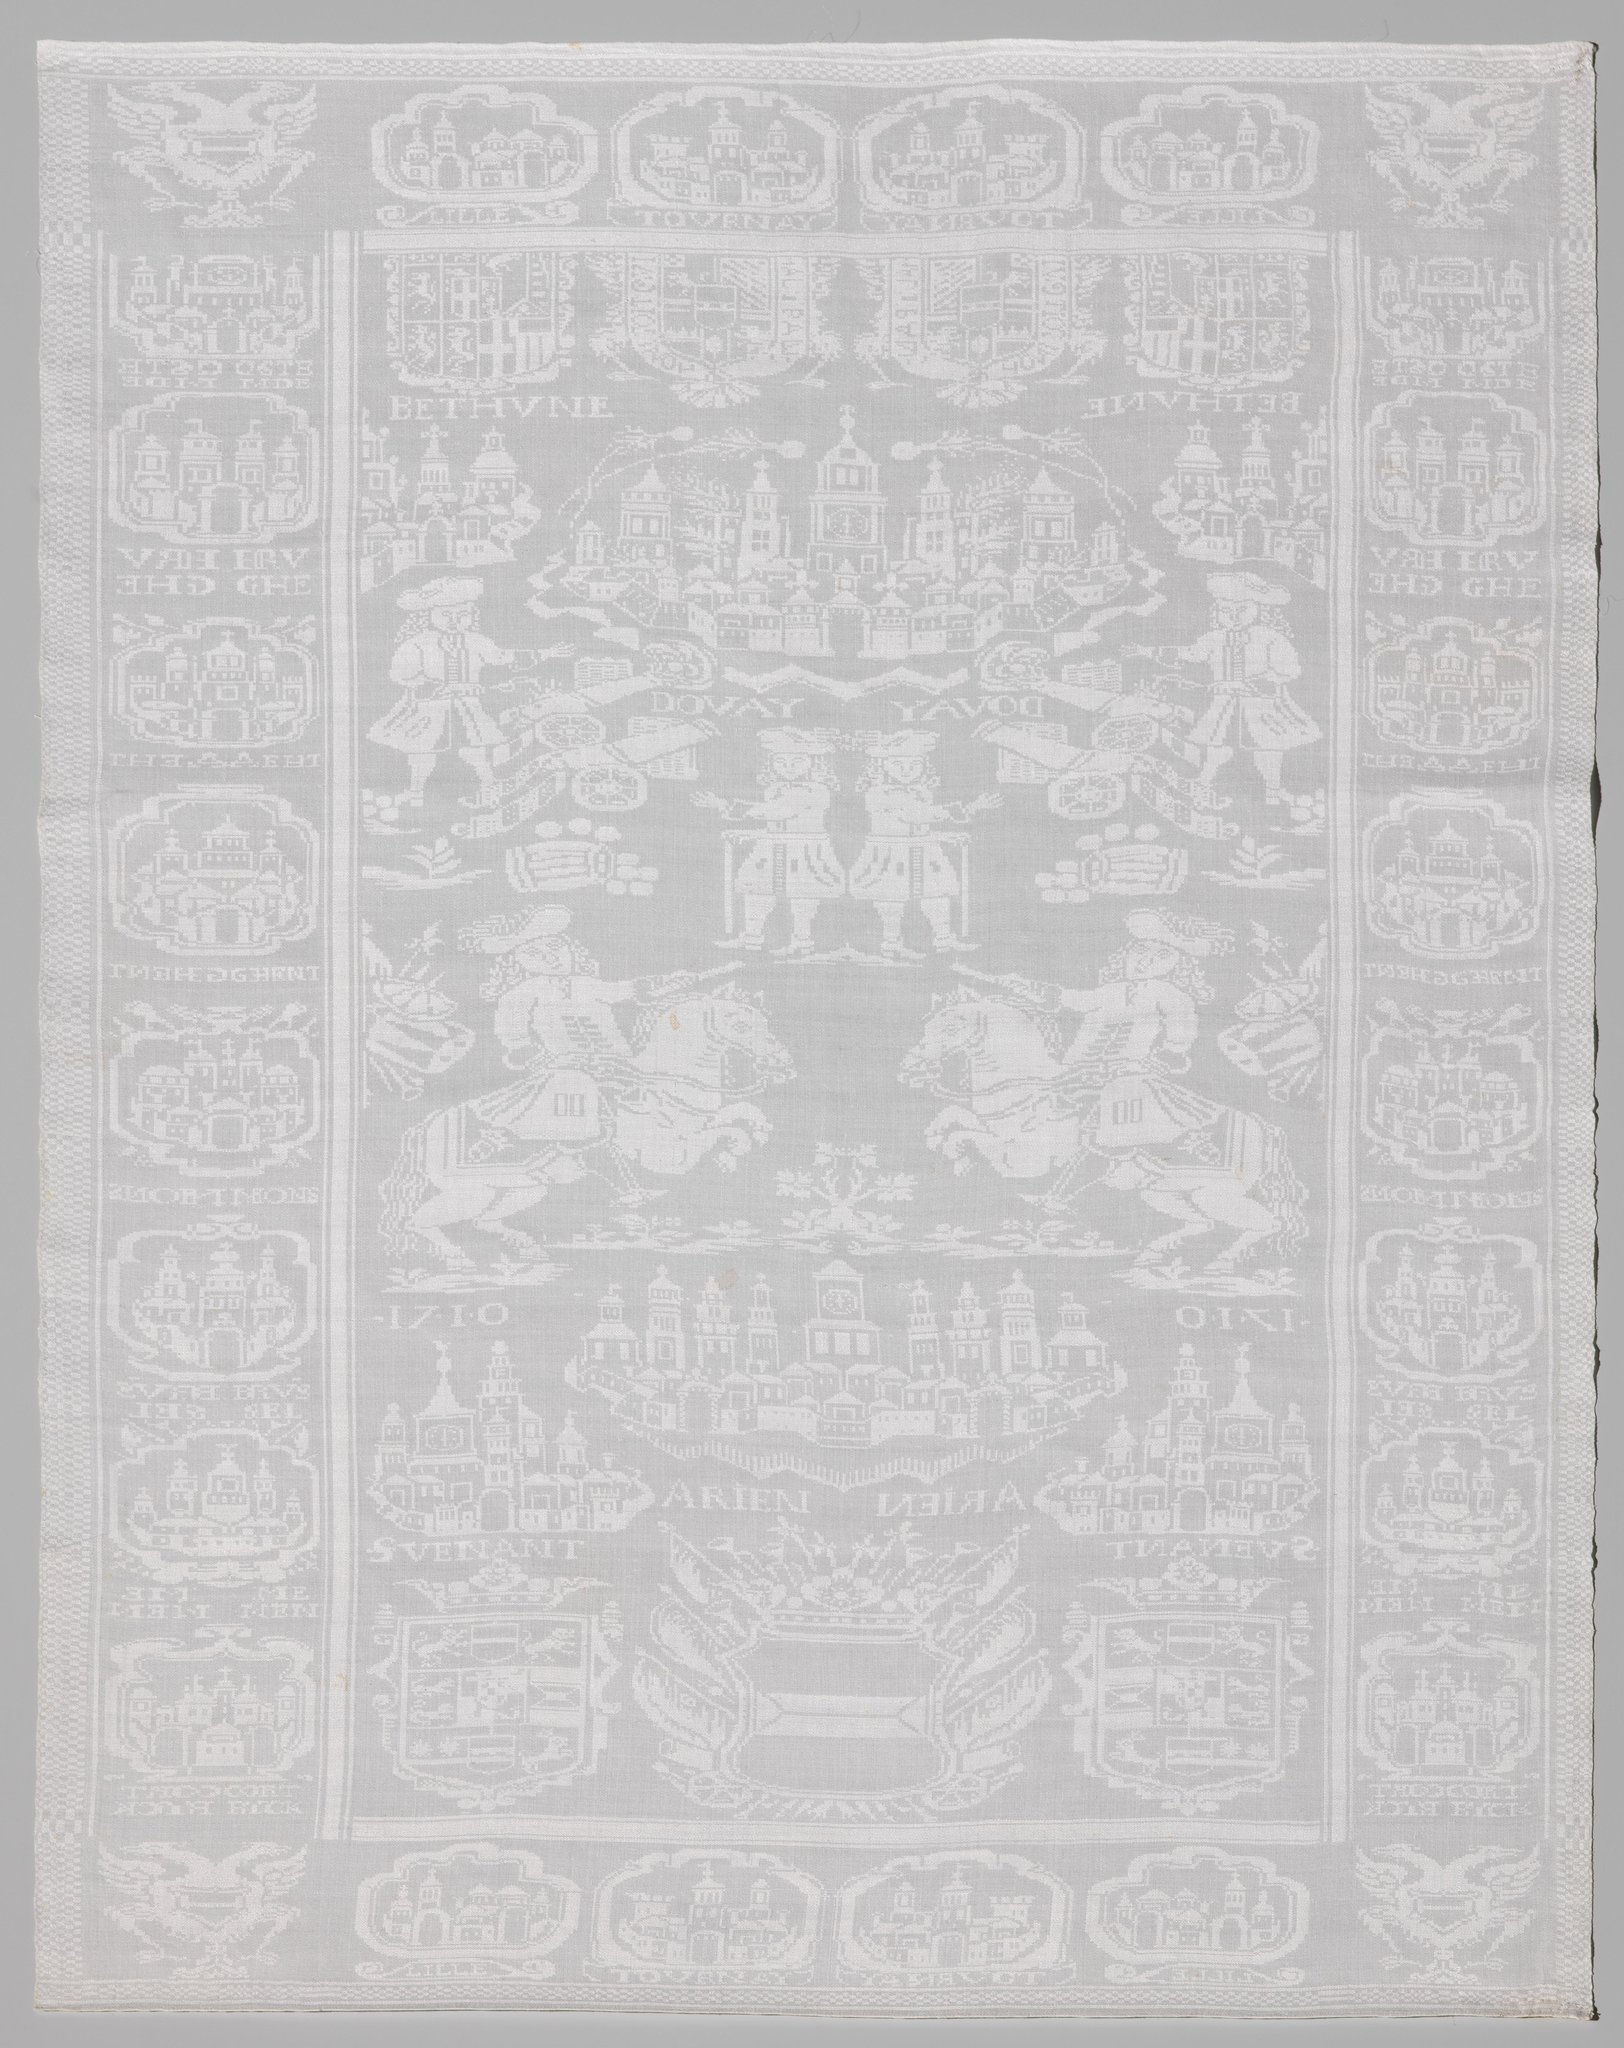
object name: napkin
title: Servet van wit linnendamast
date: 1710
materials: linen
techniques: damask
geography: flanders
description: Wit linnen damasten servet met de verovering van St. Venant, Doornik en Bethune onder Marlborough, Eugenius van Savoye en Johan Willem Friso. In een van de hoeken zijn de letters M.M. geborduurd.